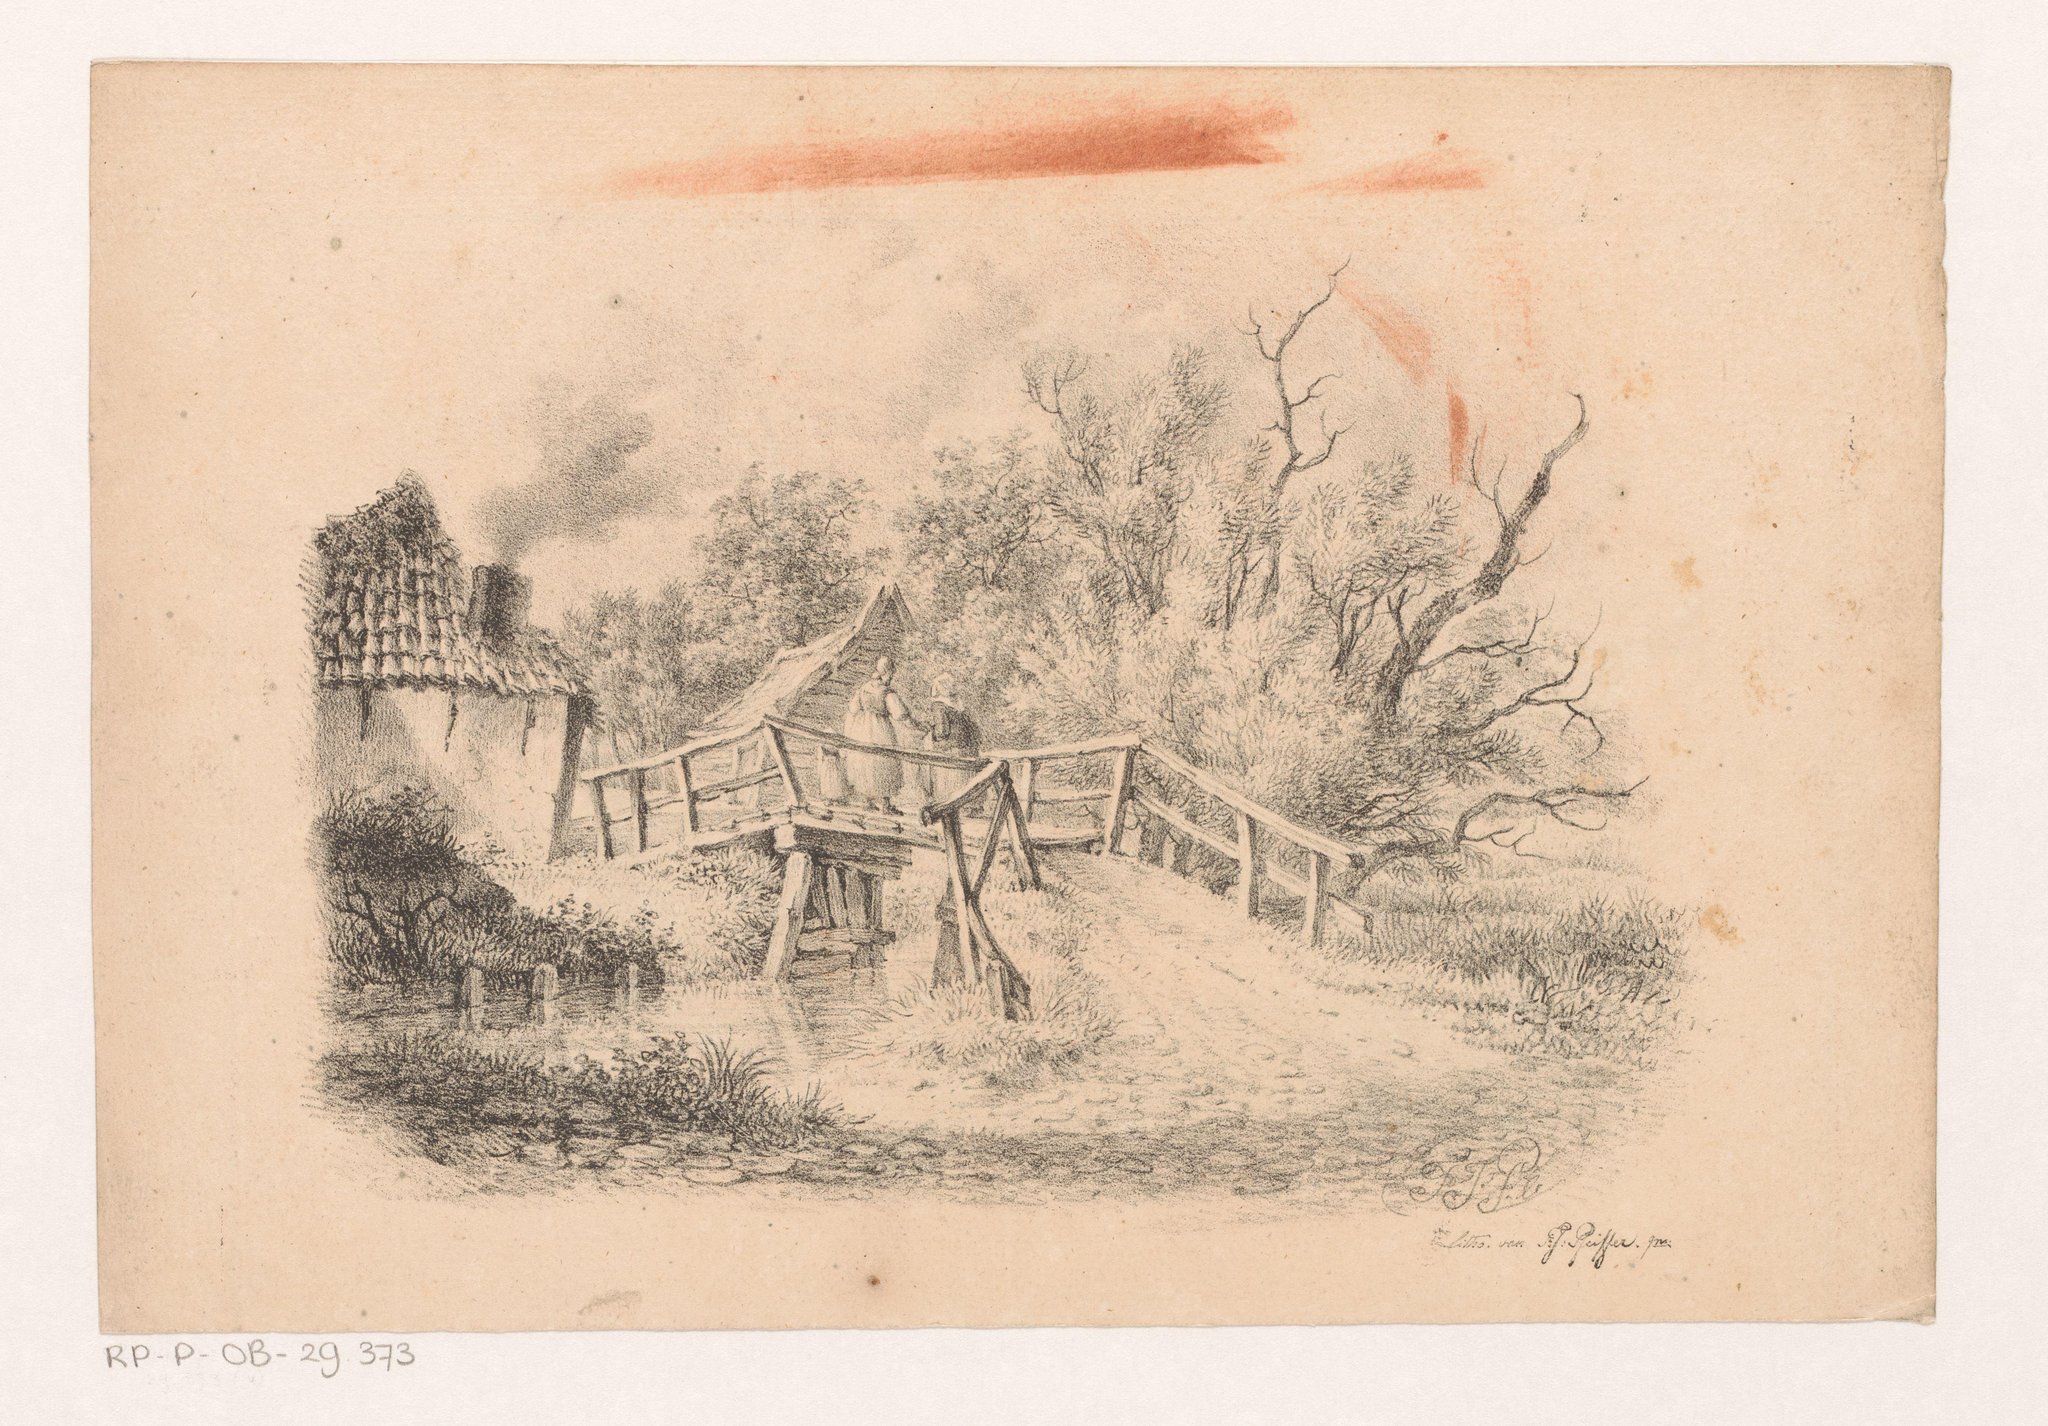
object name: print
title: Landschap met brug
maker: françois joseph pfeiffer (ii)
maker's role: draughtsman, print maker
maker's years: 1778-1835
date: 1809-1835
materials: paper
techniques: lithograph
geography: amsterdam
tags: landscapes, bridge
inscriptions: collector's mark: Lugt 2228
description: Twee vrouwen en een meisje staan op een brug over een smalle rivier.